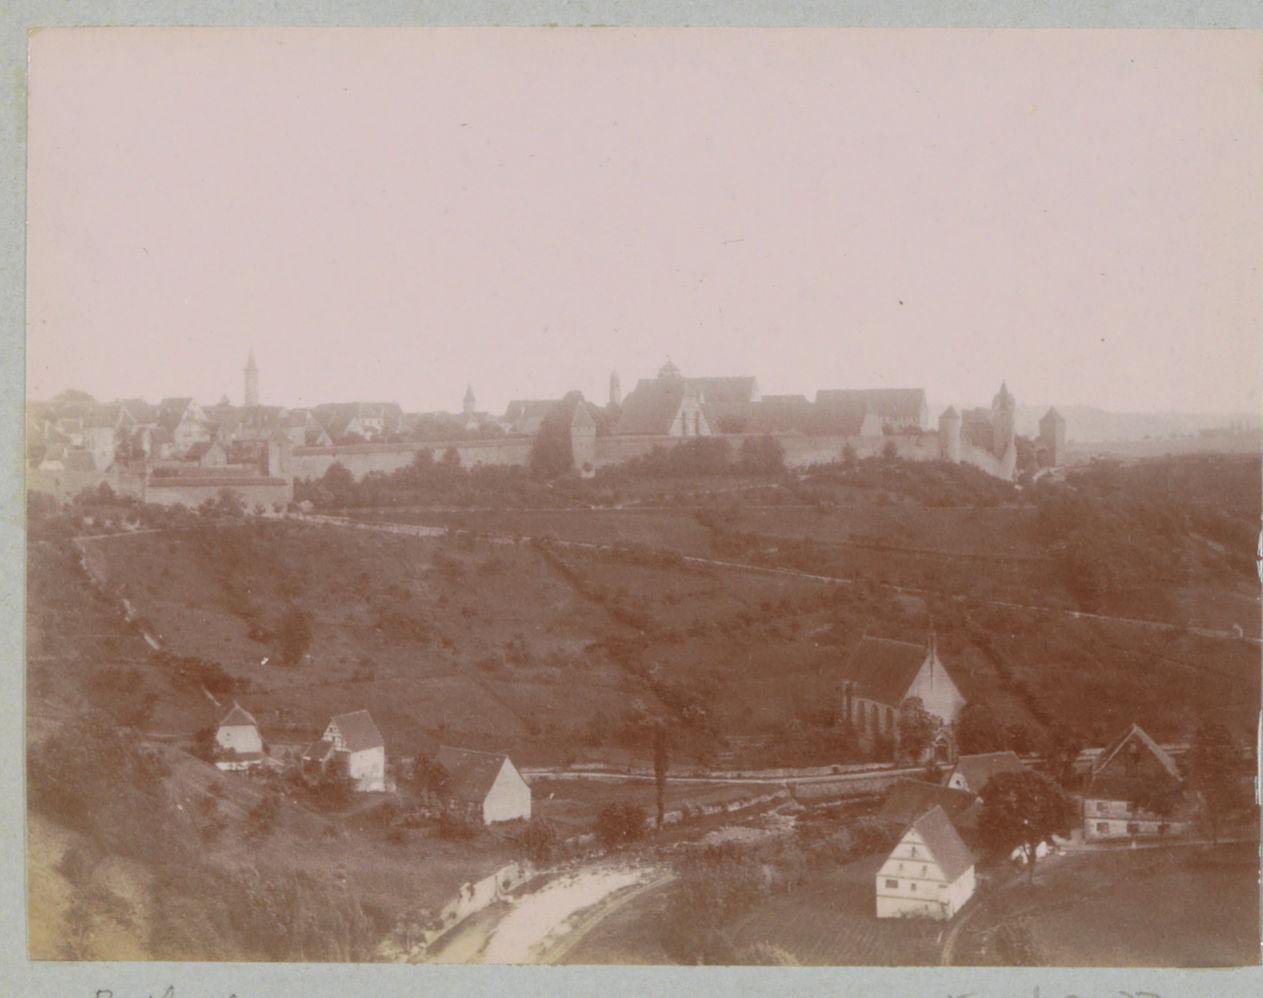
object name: photograph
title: Gezicht op Rothenburg ob der Tauber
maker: delizy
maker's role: manufacturer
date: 1900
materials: paper, photographic support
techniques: gelatin silver print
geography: rothenburg ob der tauber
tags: prospect of village, silhouette of village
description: Onderdeel van Fotoalbum van een Franse amateurfotograaf met opnames van uitstapjes in Frankrijk, Spanje, België, Luxemburg en Nederland, de eerste automobielen en autoraces.